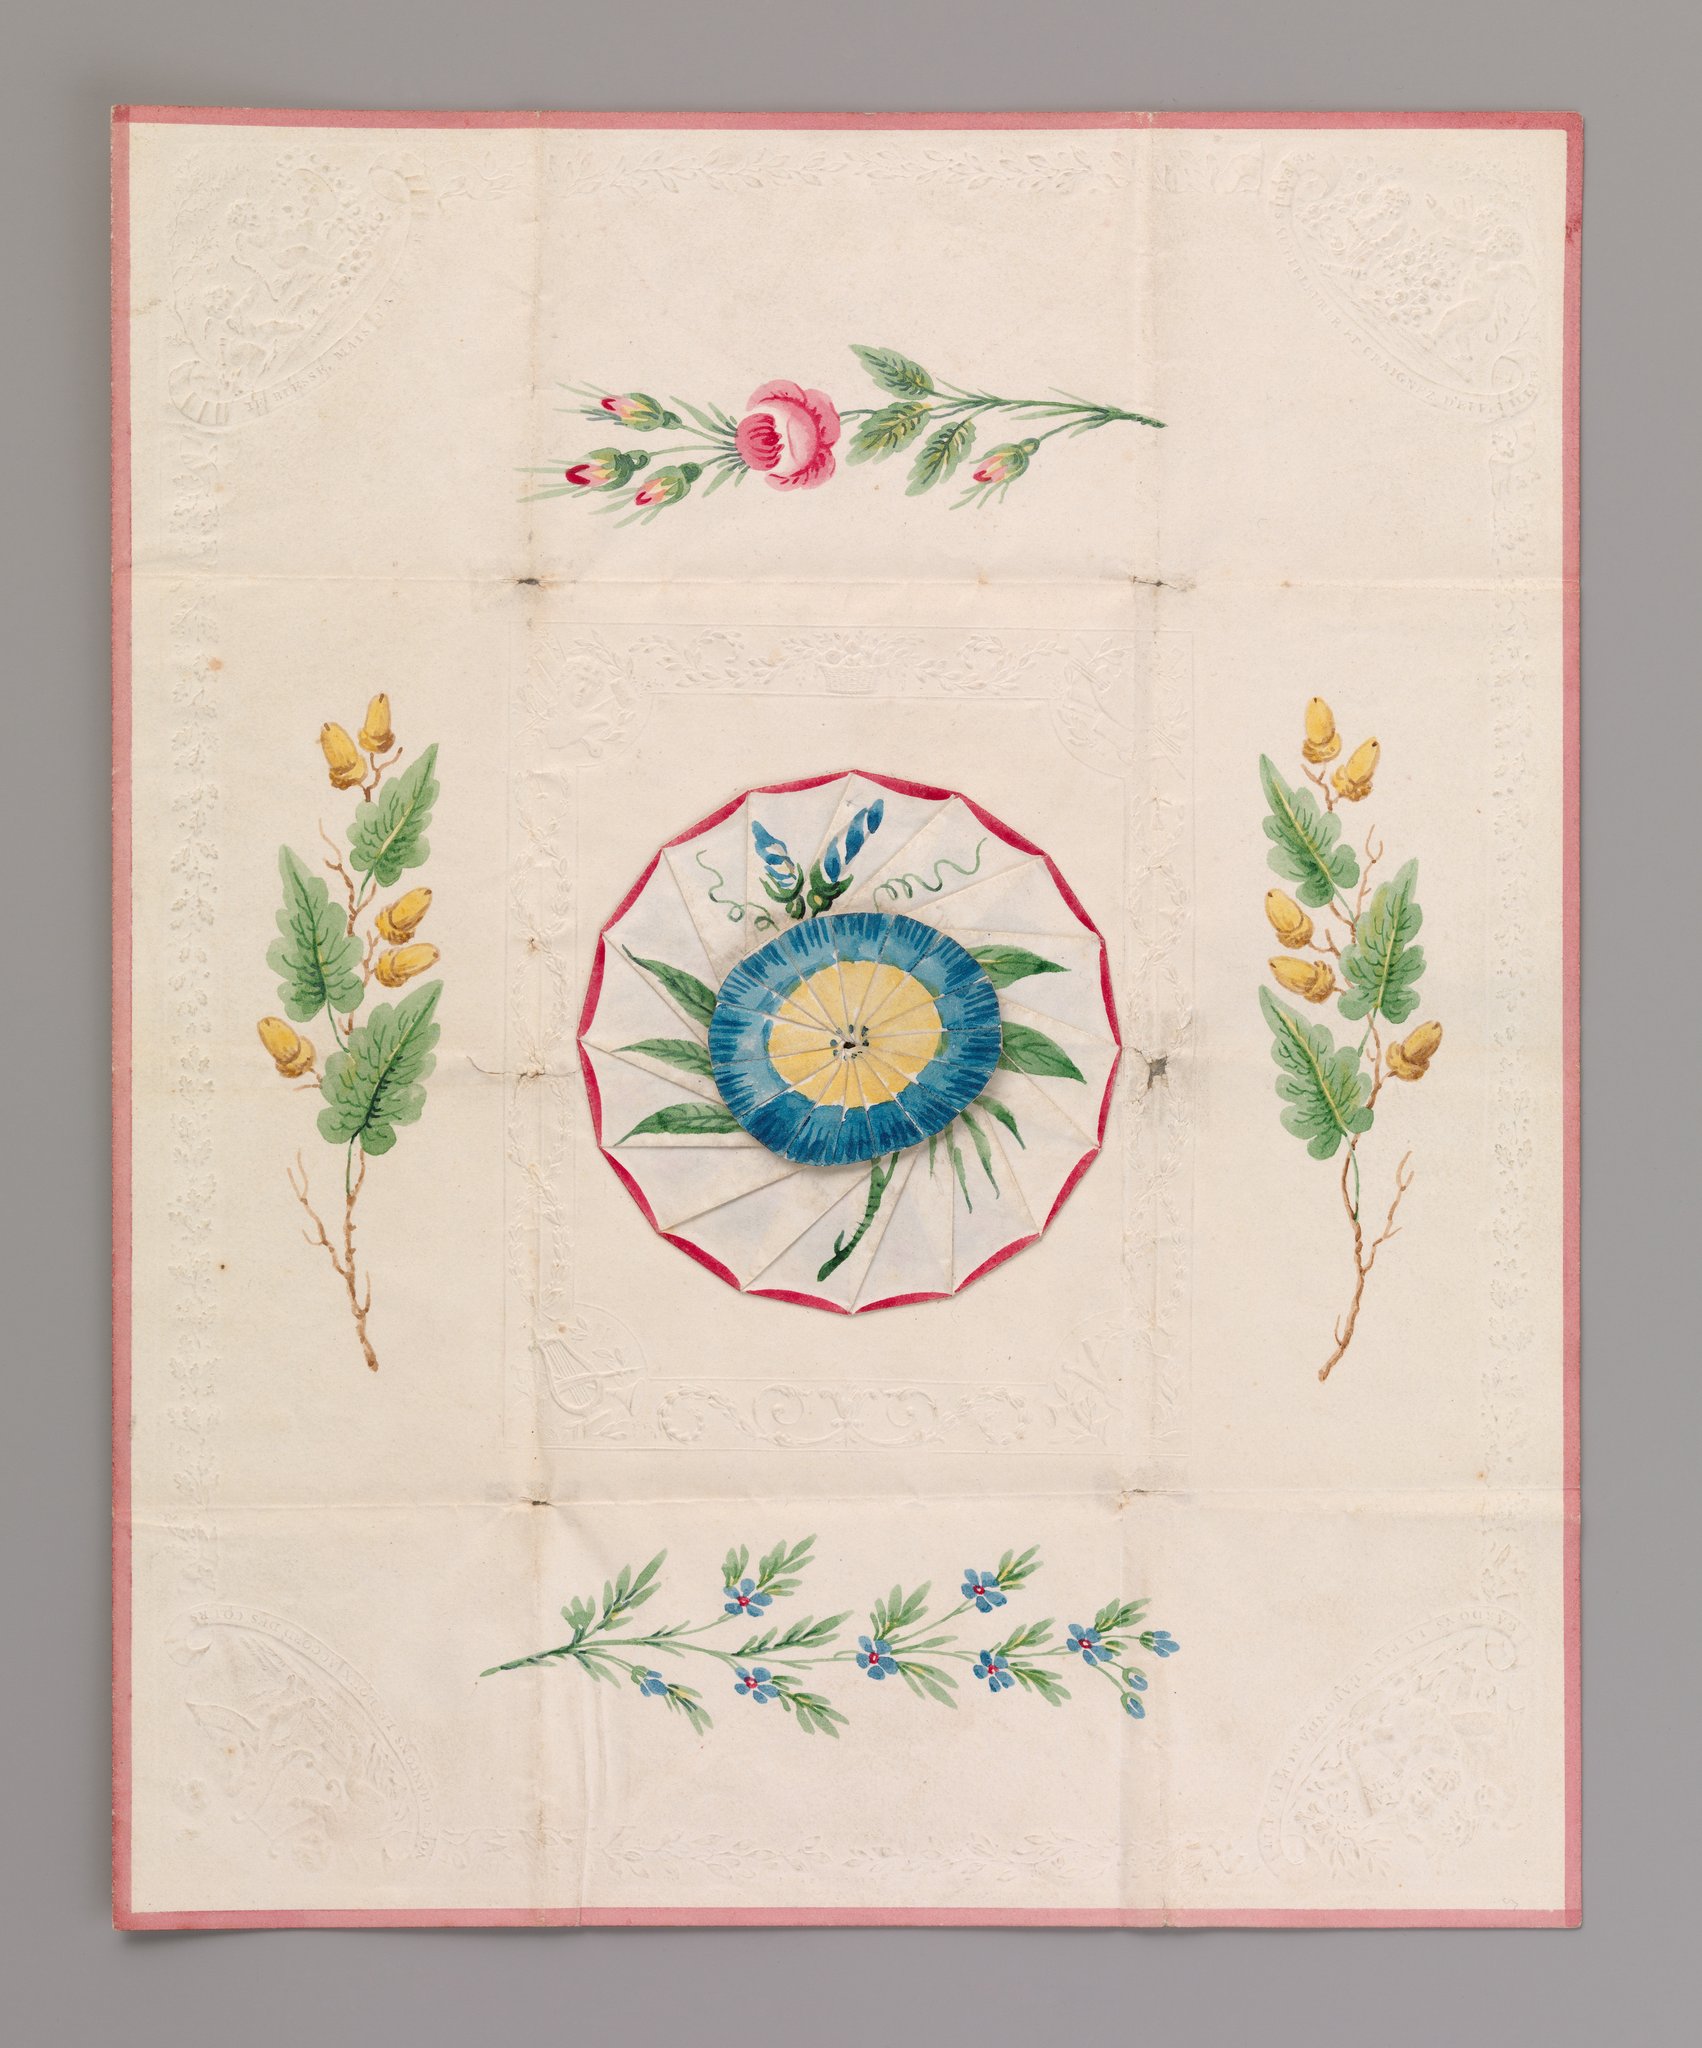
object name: valentine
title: Cobweb Valentine with Morning Glory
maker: anonymous, british, 19th century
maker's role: artist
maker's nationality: british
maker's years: 1800-1900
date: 1840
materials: ink, paper, watercolor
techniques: embossing, pen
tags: flowers,leaves